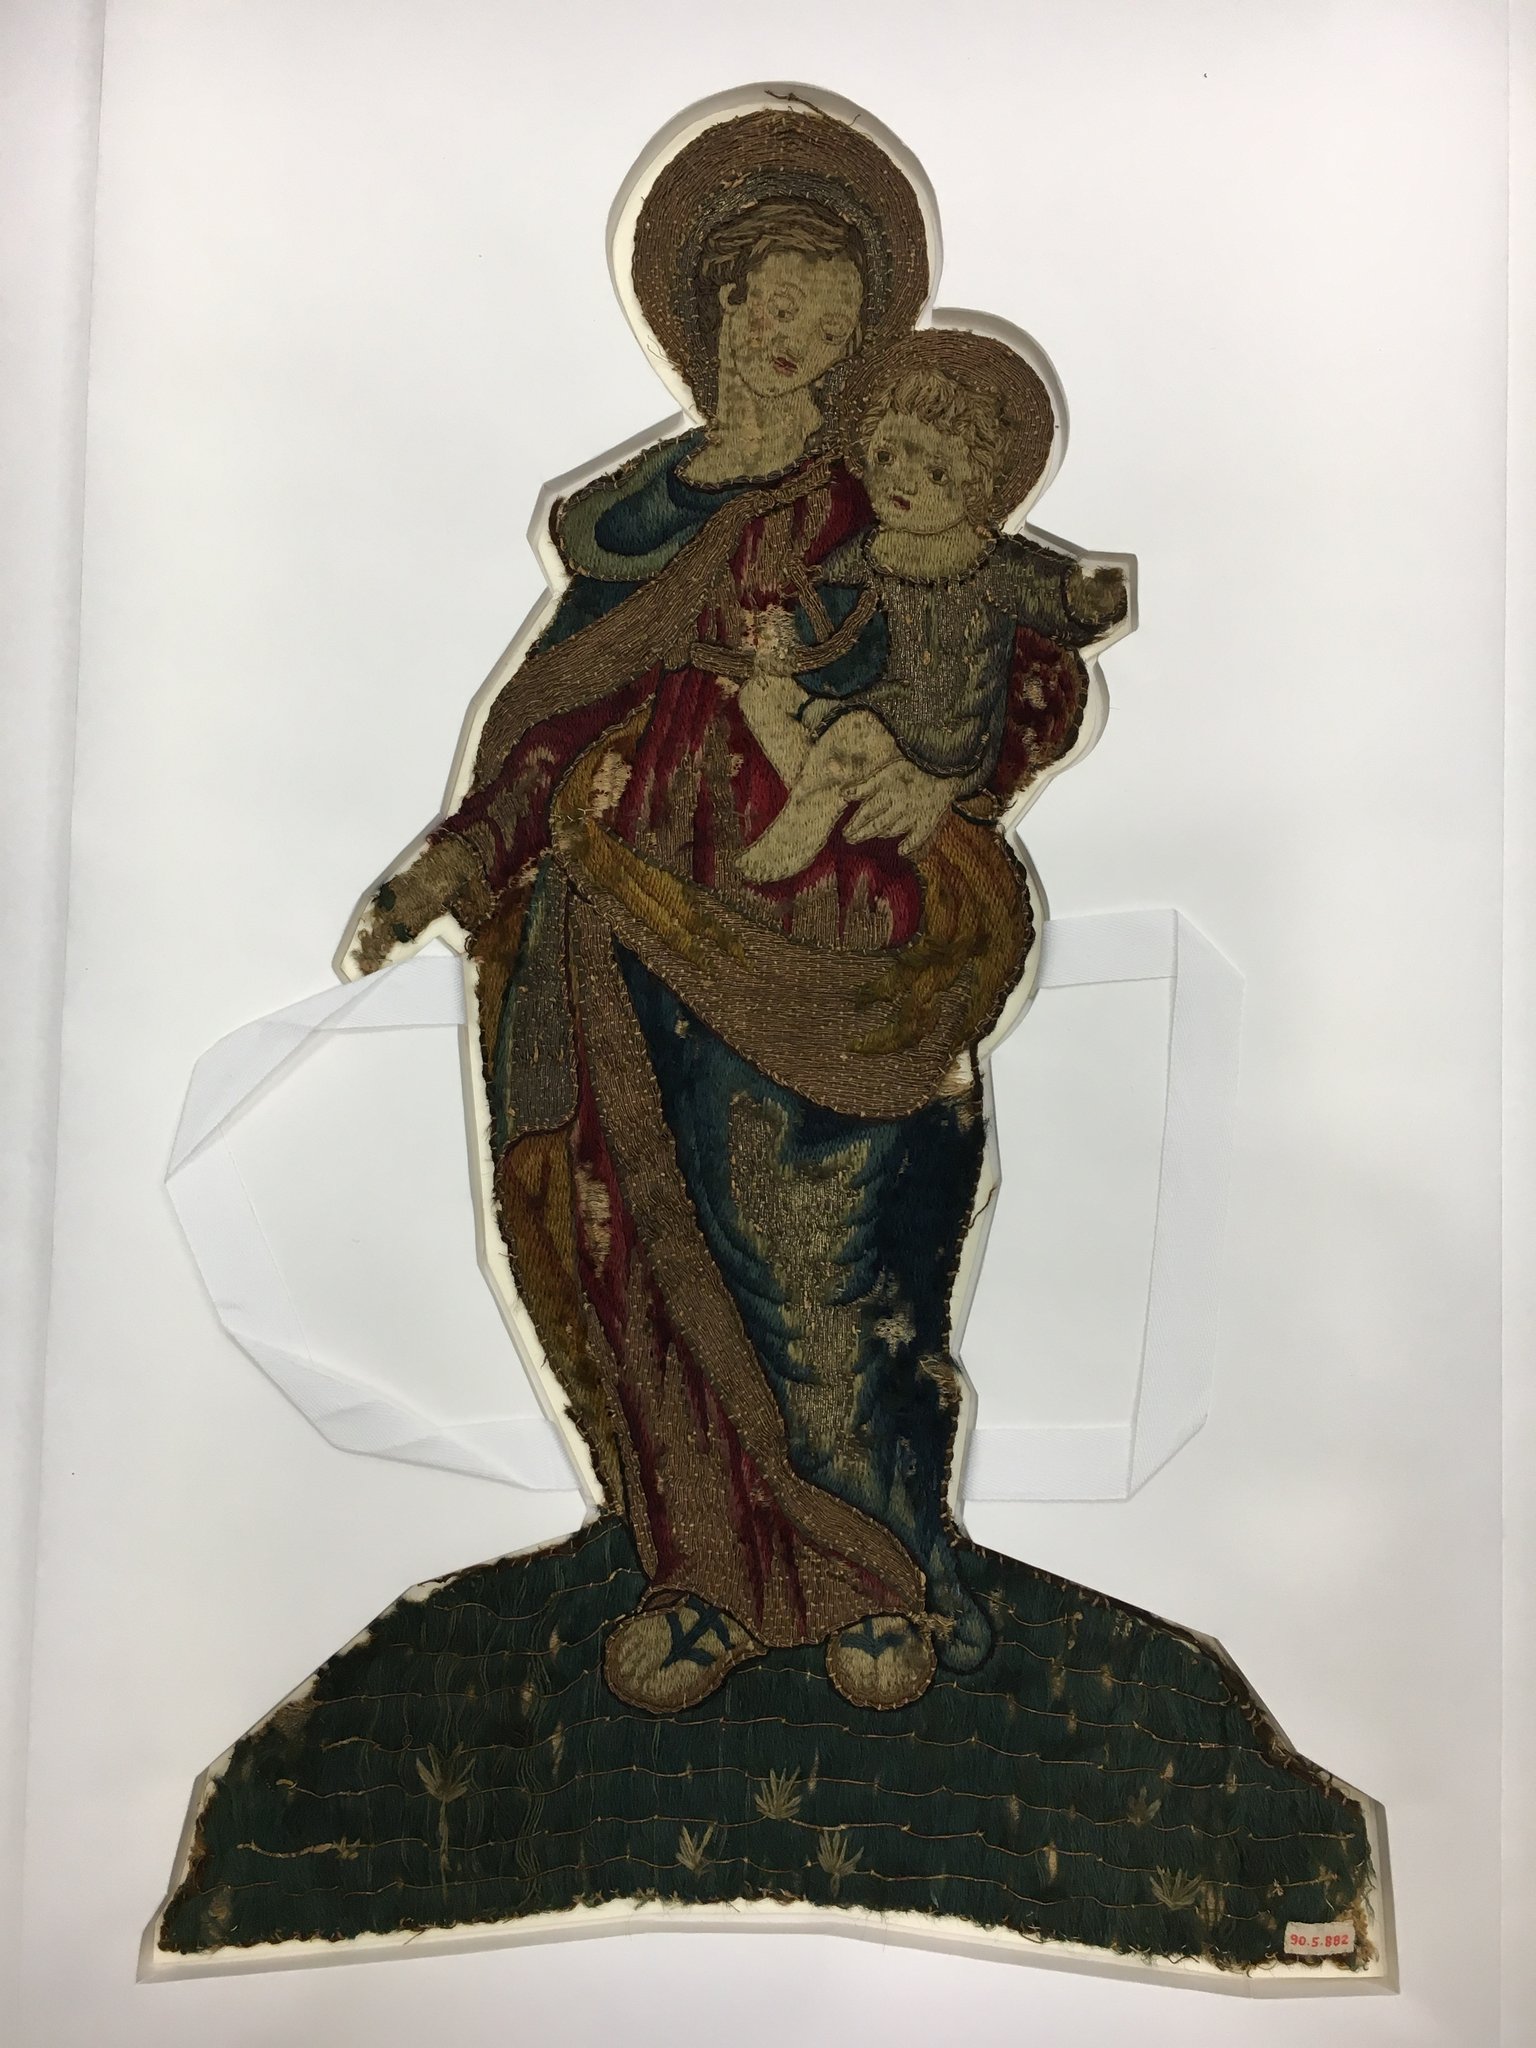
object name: appliqué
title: Virgin and Child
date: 1501-1600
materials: linen, metal thread, silk, wool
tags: madonna and child